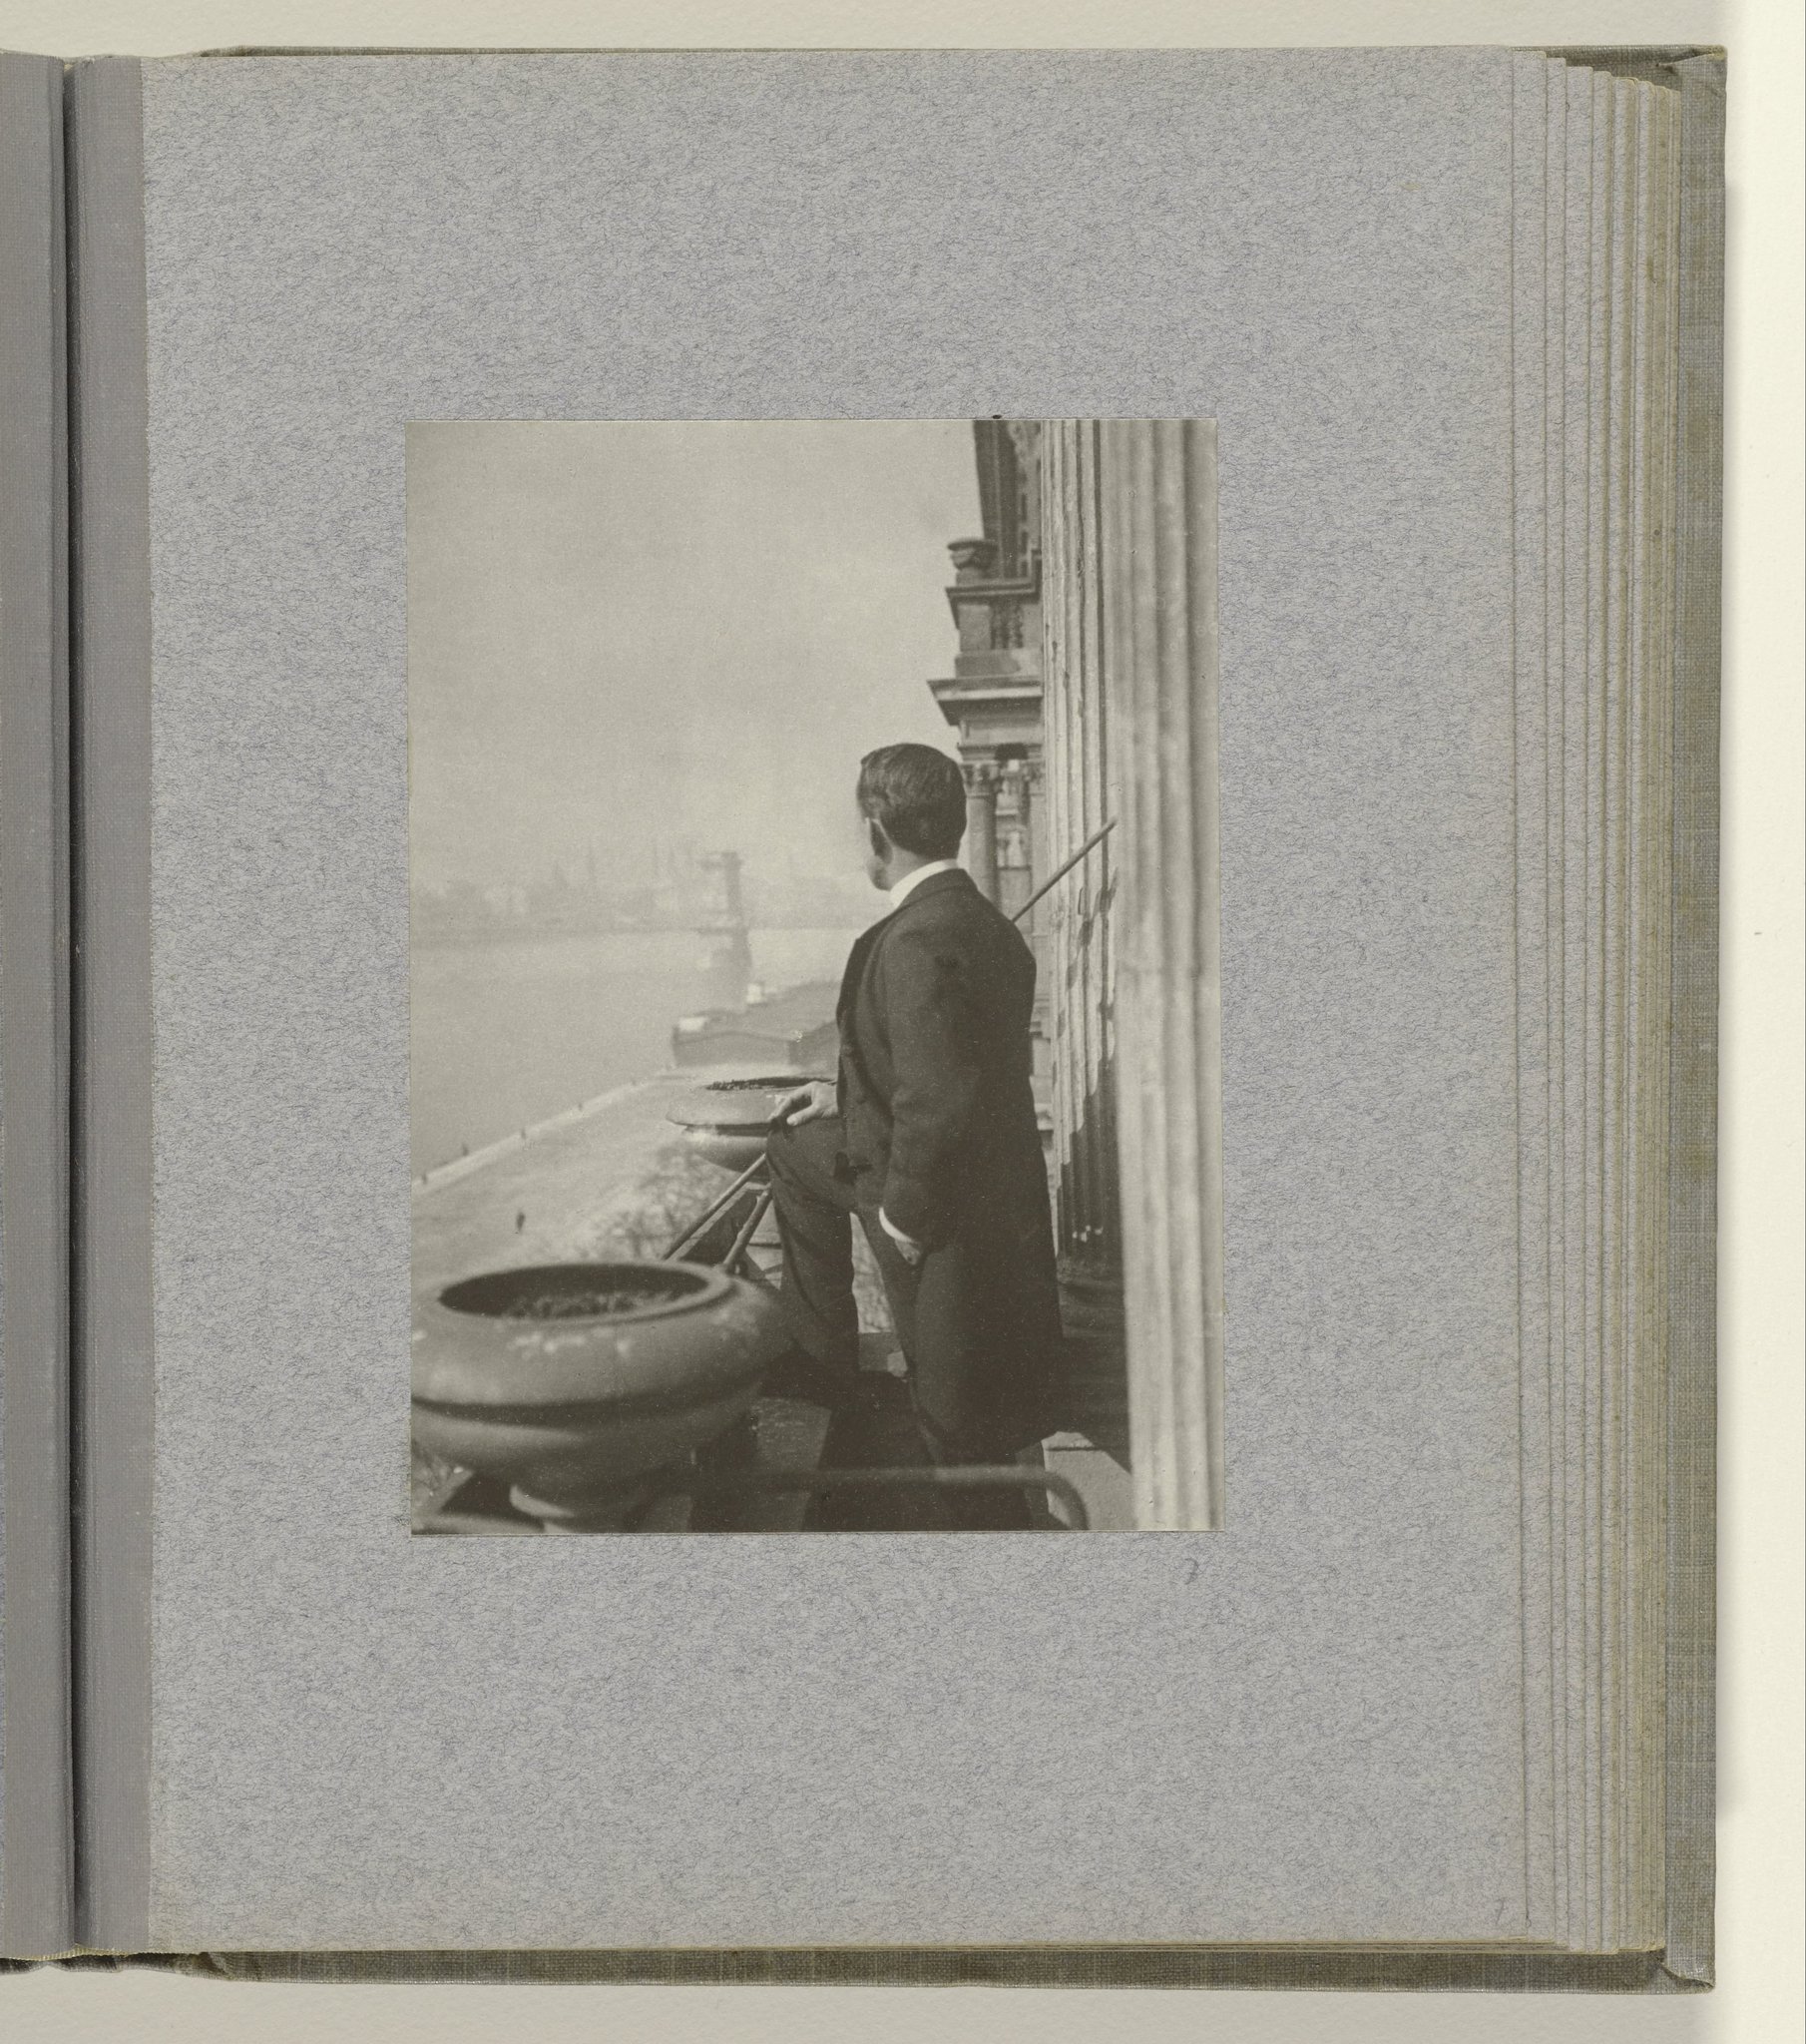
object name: photograph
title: J.B. Aug. Kessler op het balkon van zijn hotelkamer uitkijkend over het water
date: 1900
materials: paper, photographic support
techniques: gelatin silver print